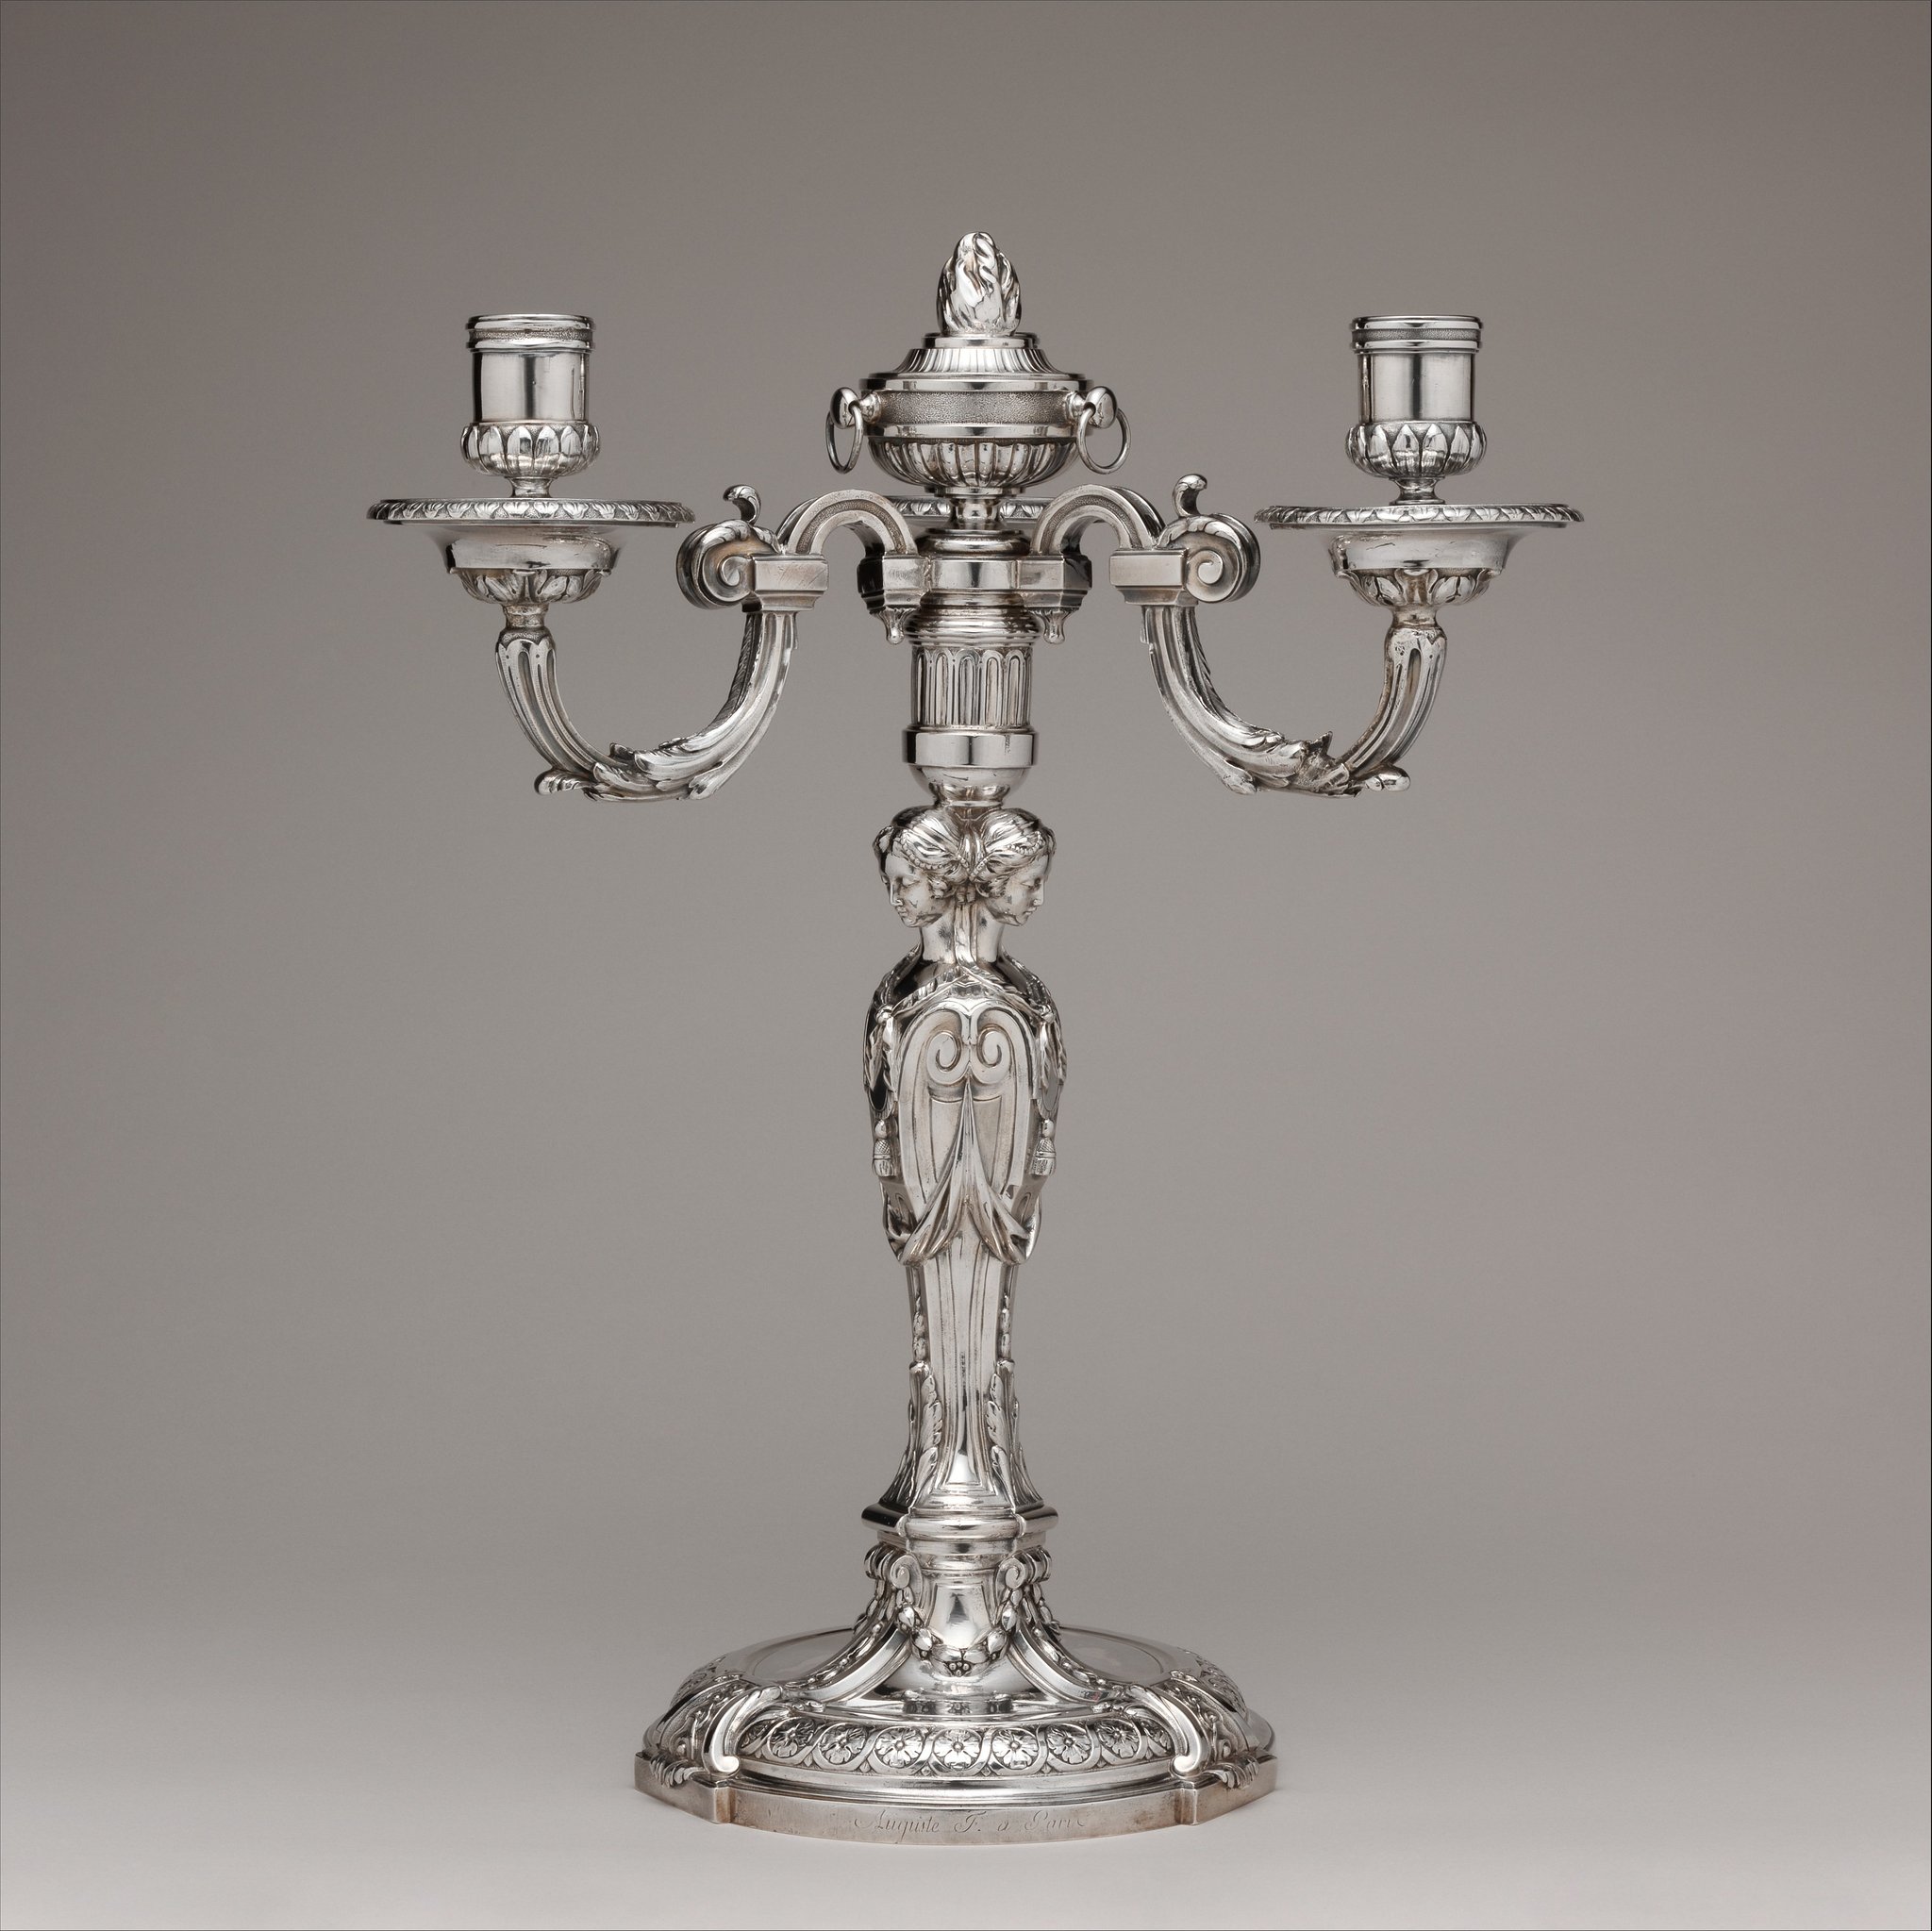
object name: candelabrum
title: Candelabrum (one of a pair)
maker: robert joseph auguste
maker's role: maker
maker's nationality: french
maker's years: 1723-1805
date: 1767-1768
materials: silver